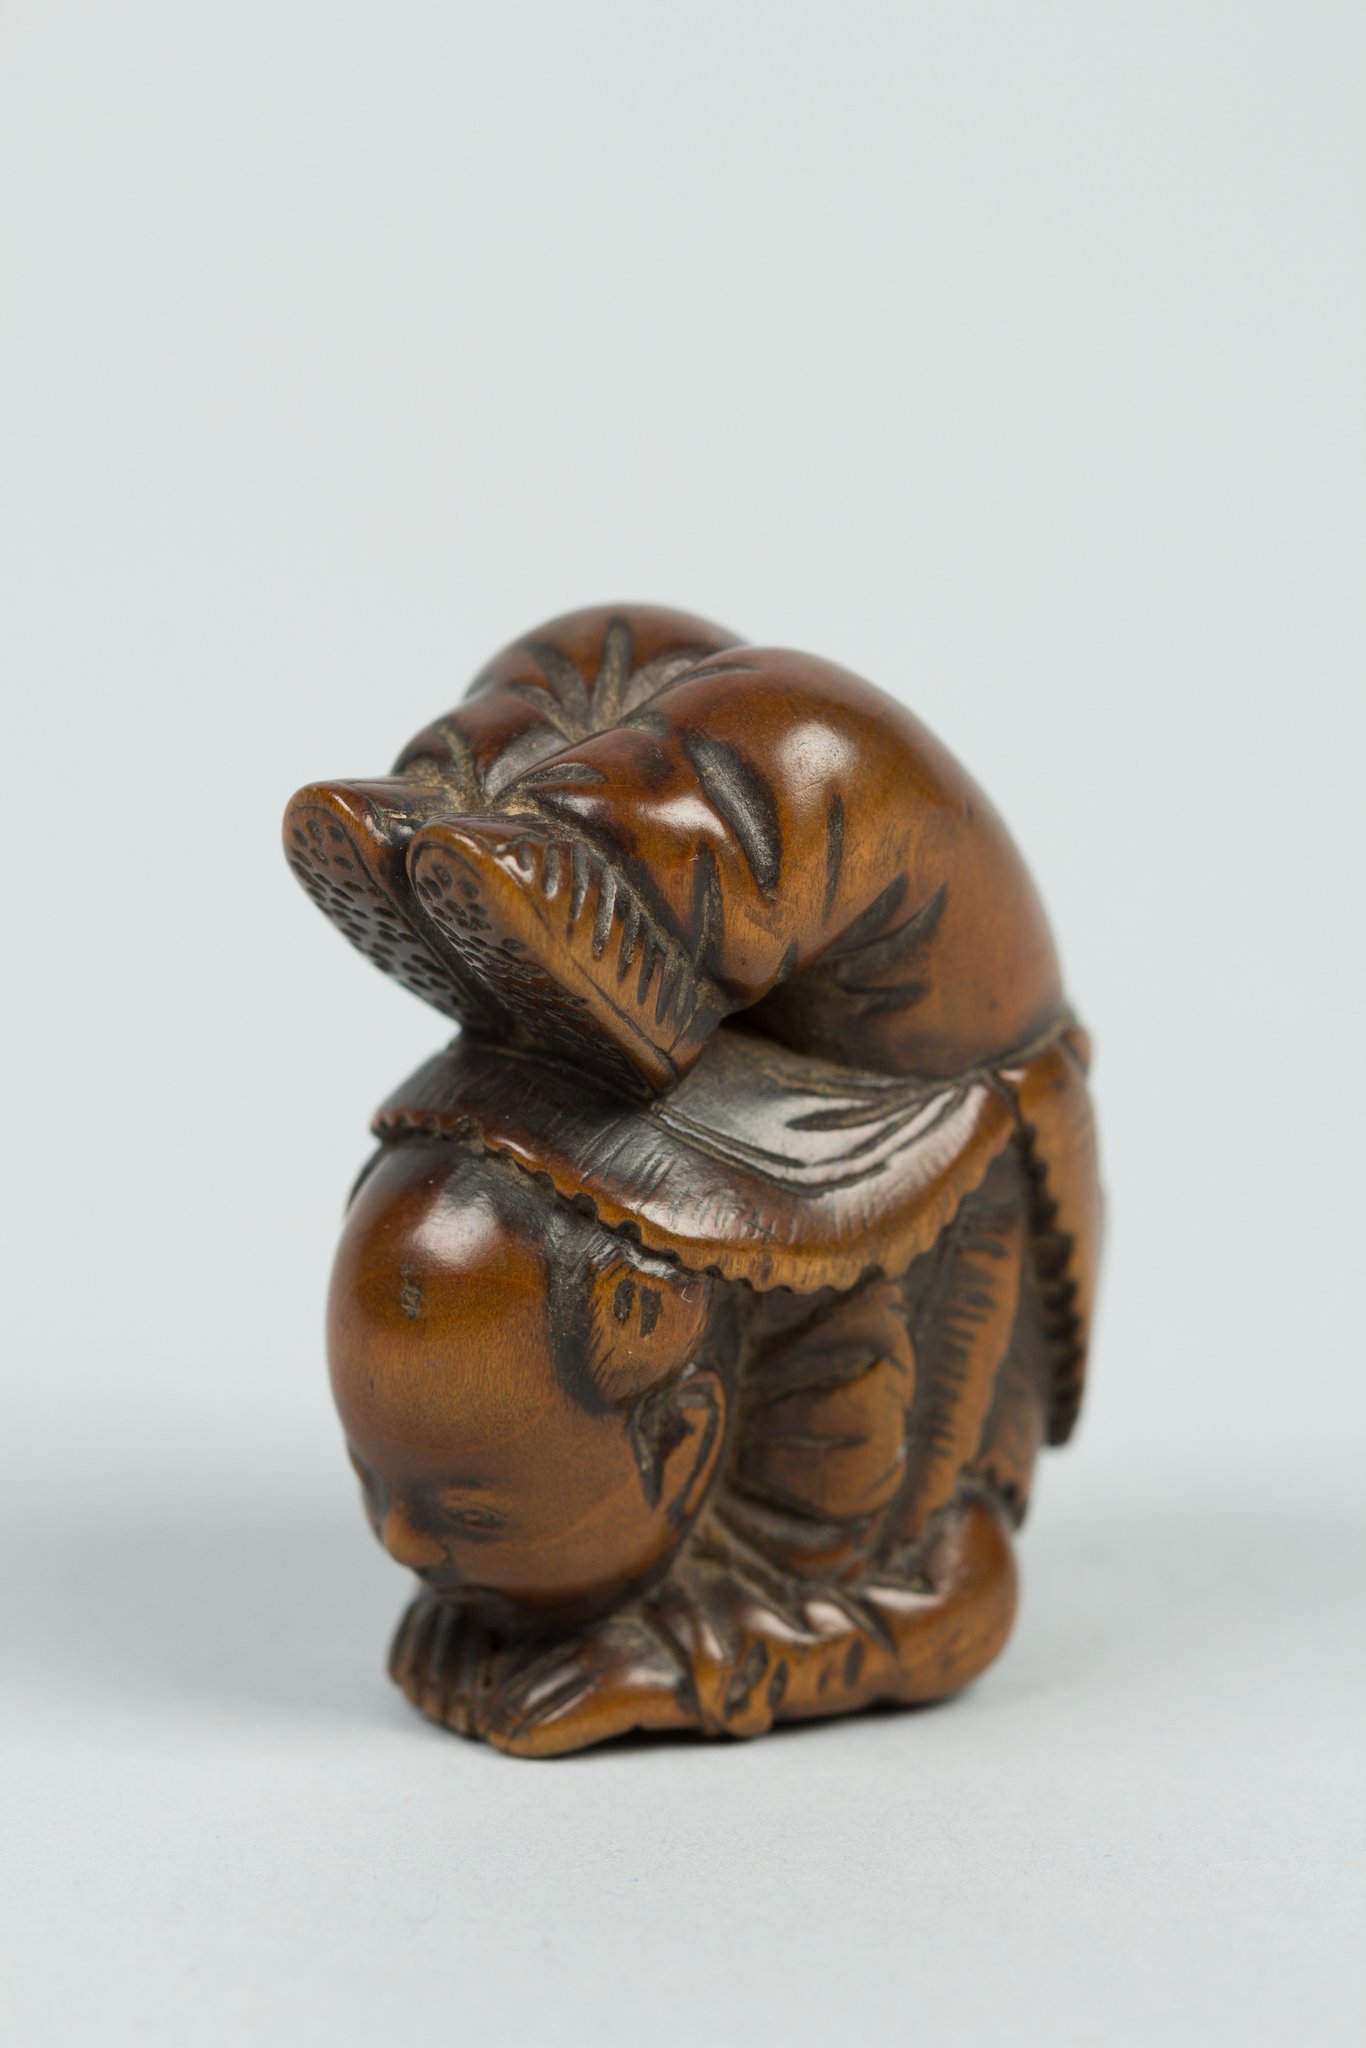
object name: netsuke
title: Netsuke of Acrobat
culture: japanese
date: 1801-1900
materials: wood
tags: men,acrobats